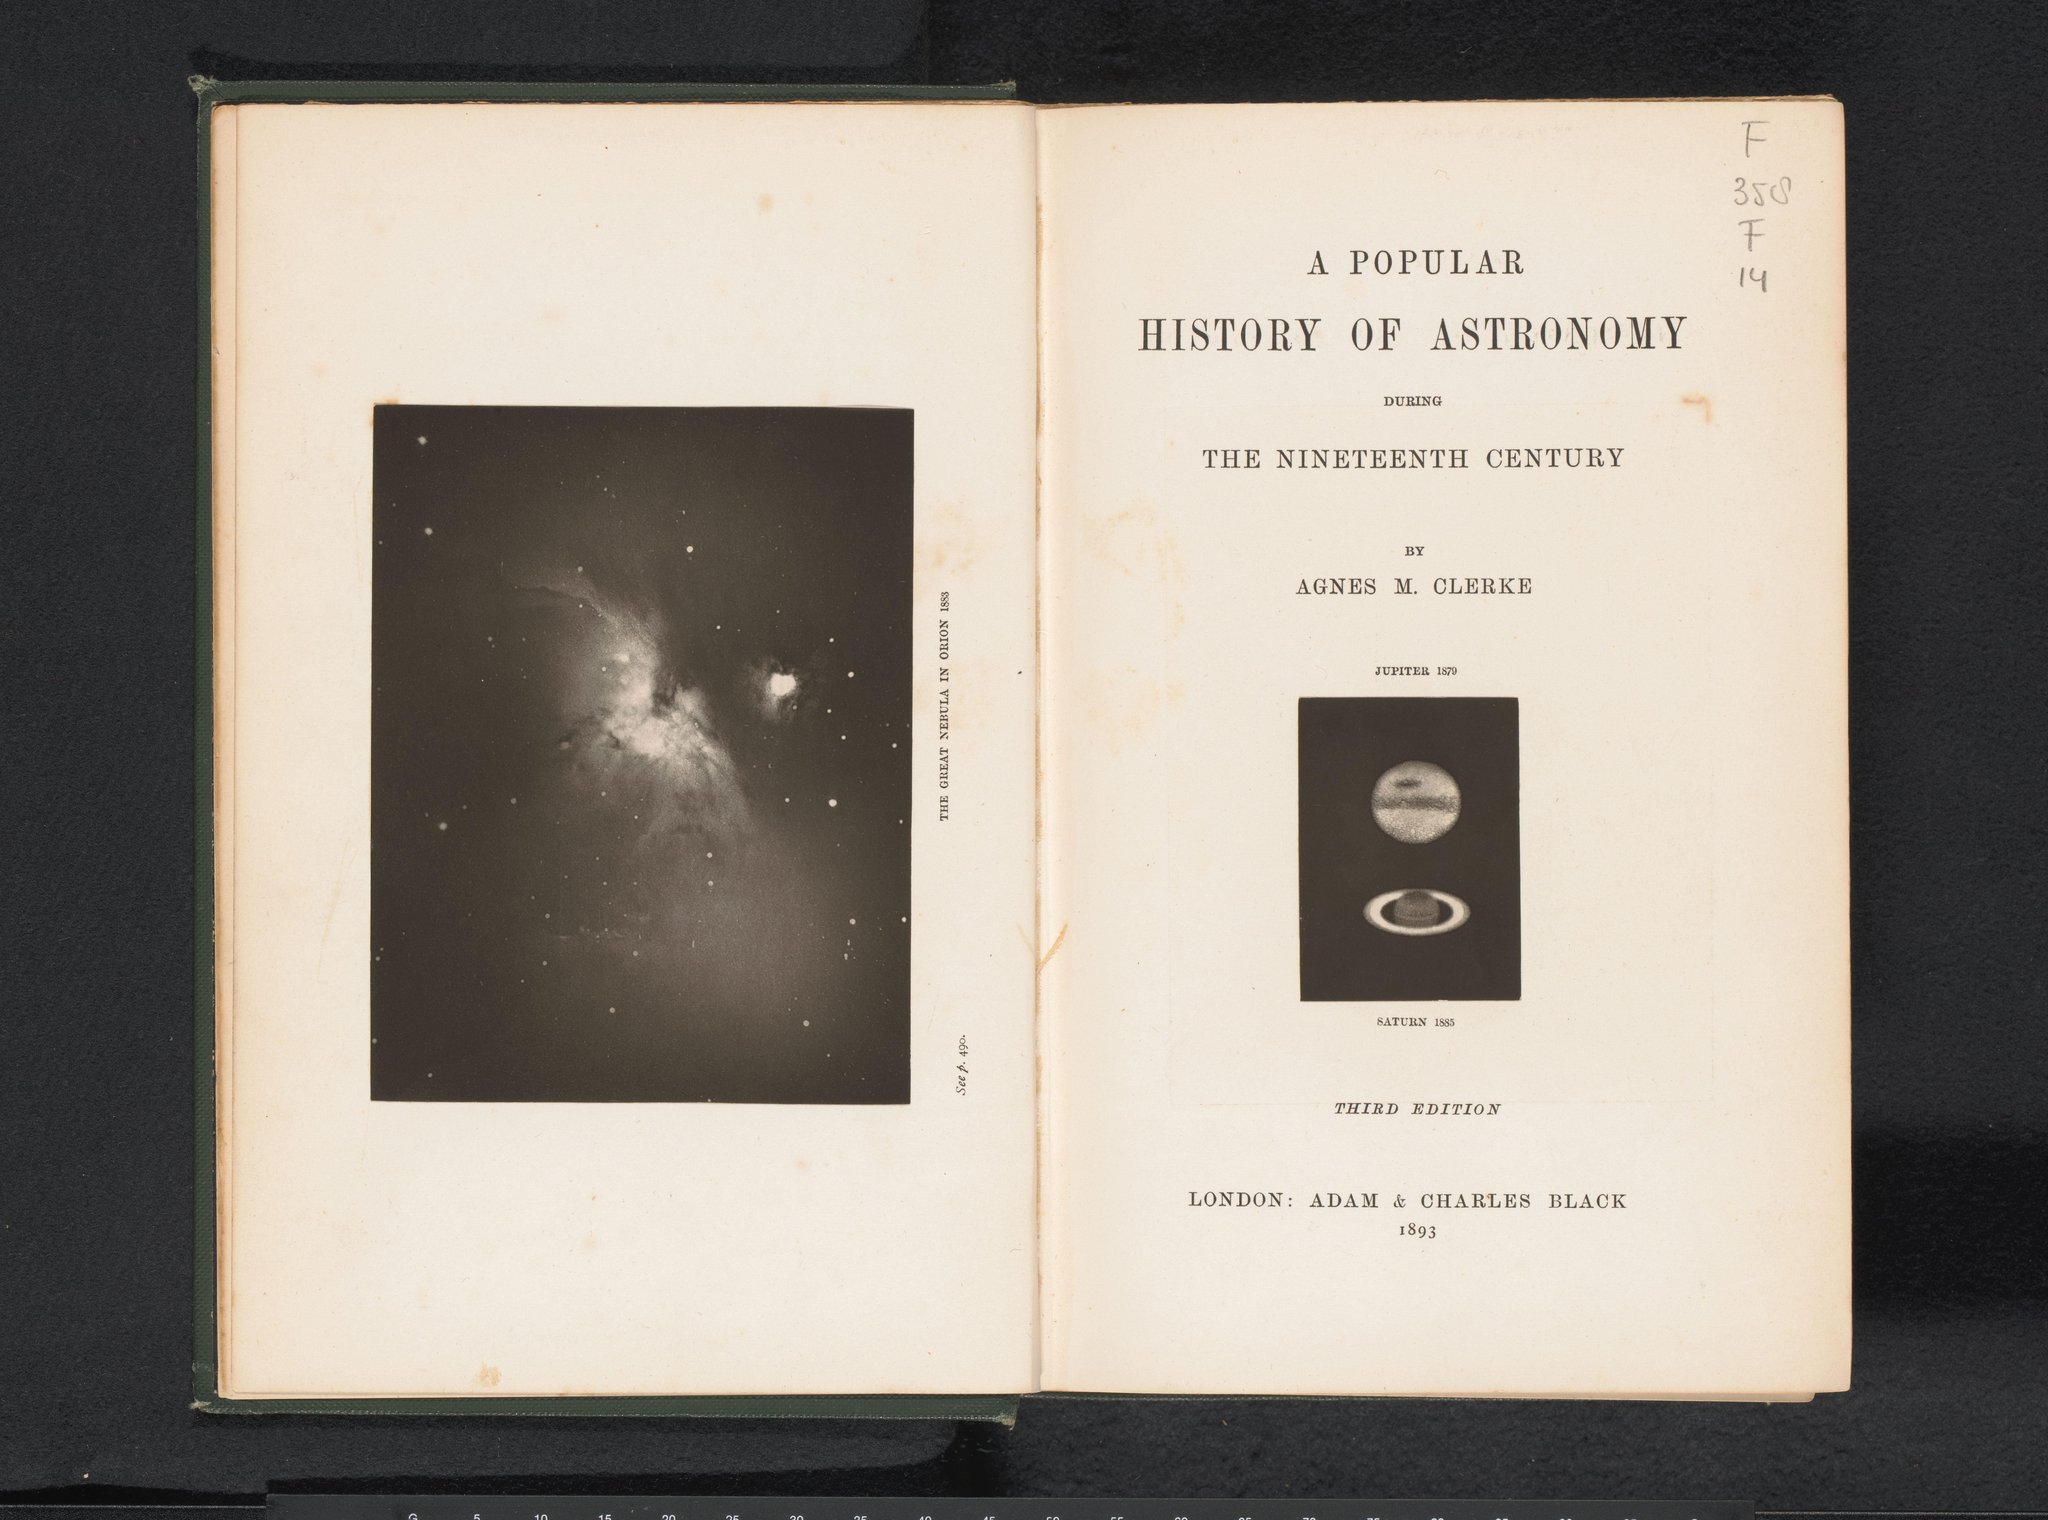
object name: photomechanical print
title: Orionnevel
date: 1883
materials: paper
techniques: woodburytype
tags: stars and constellations: orion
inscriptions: inscription: ‘See p. 490.’